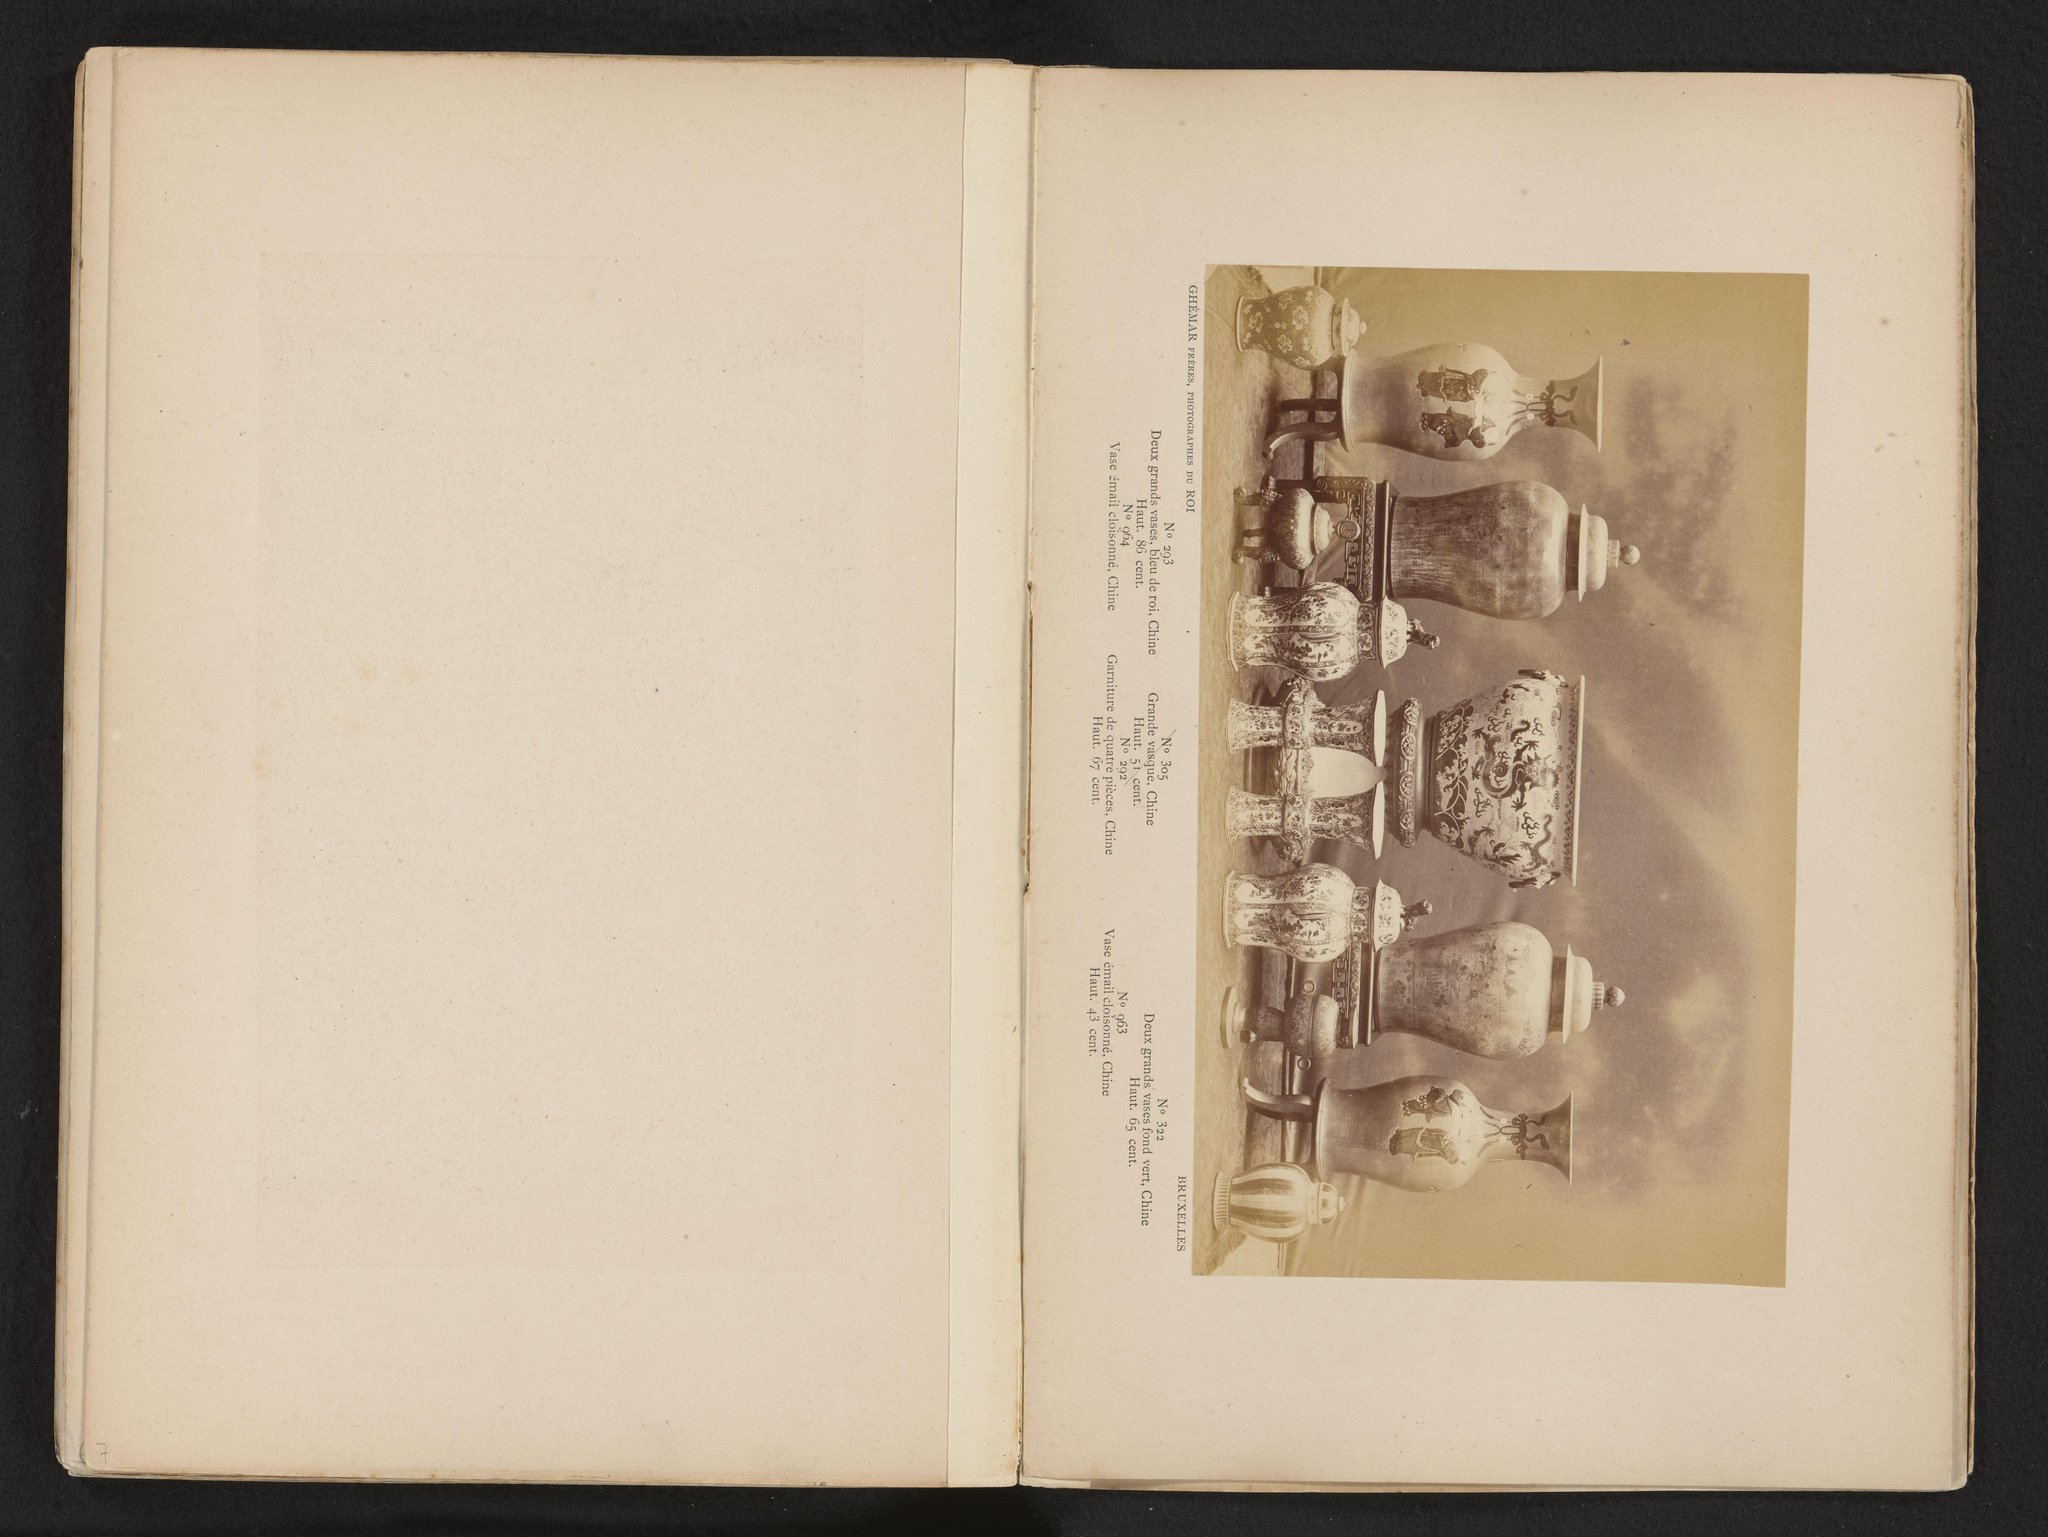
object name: page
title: Dertien objecten, waaronder Chinese vazen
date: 1870-1875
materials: photographic support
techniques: albumen print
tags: container of ceramics: jar, jug, pot, vase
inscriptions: inscription: ‘No. 293 Deux grandes vases, bleu de roi, Chine Haut 86 cent. (...)’